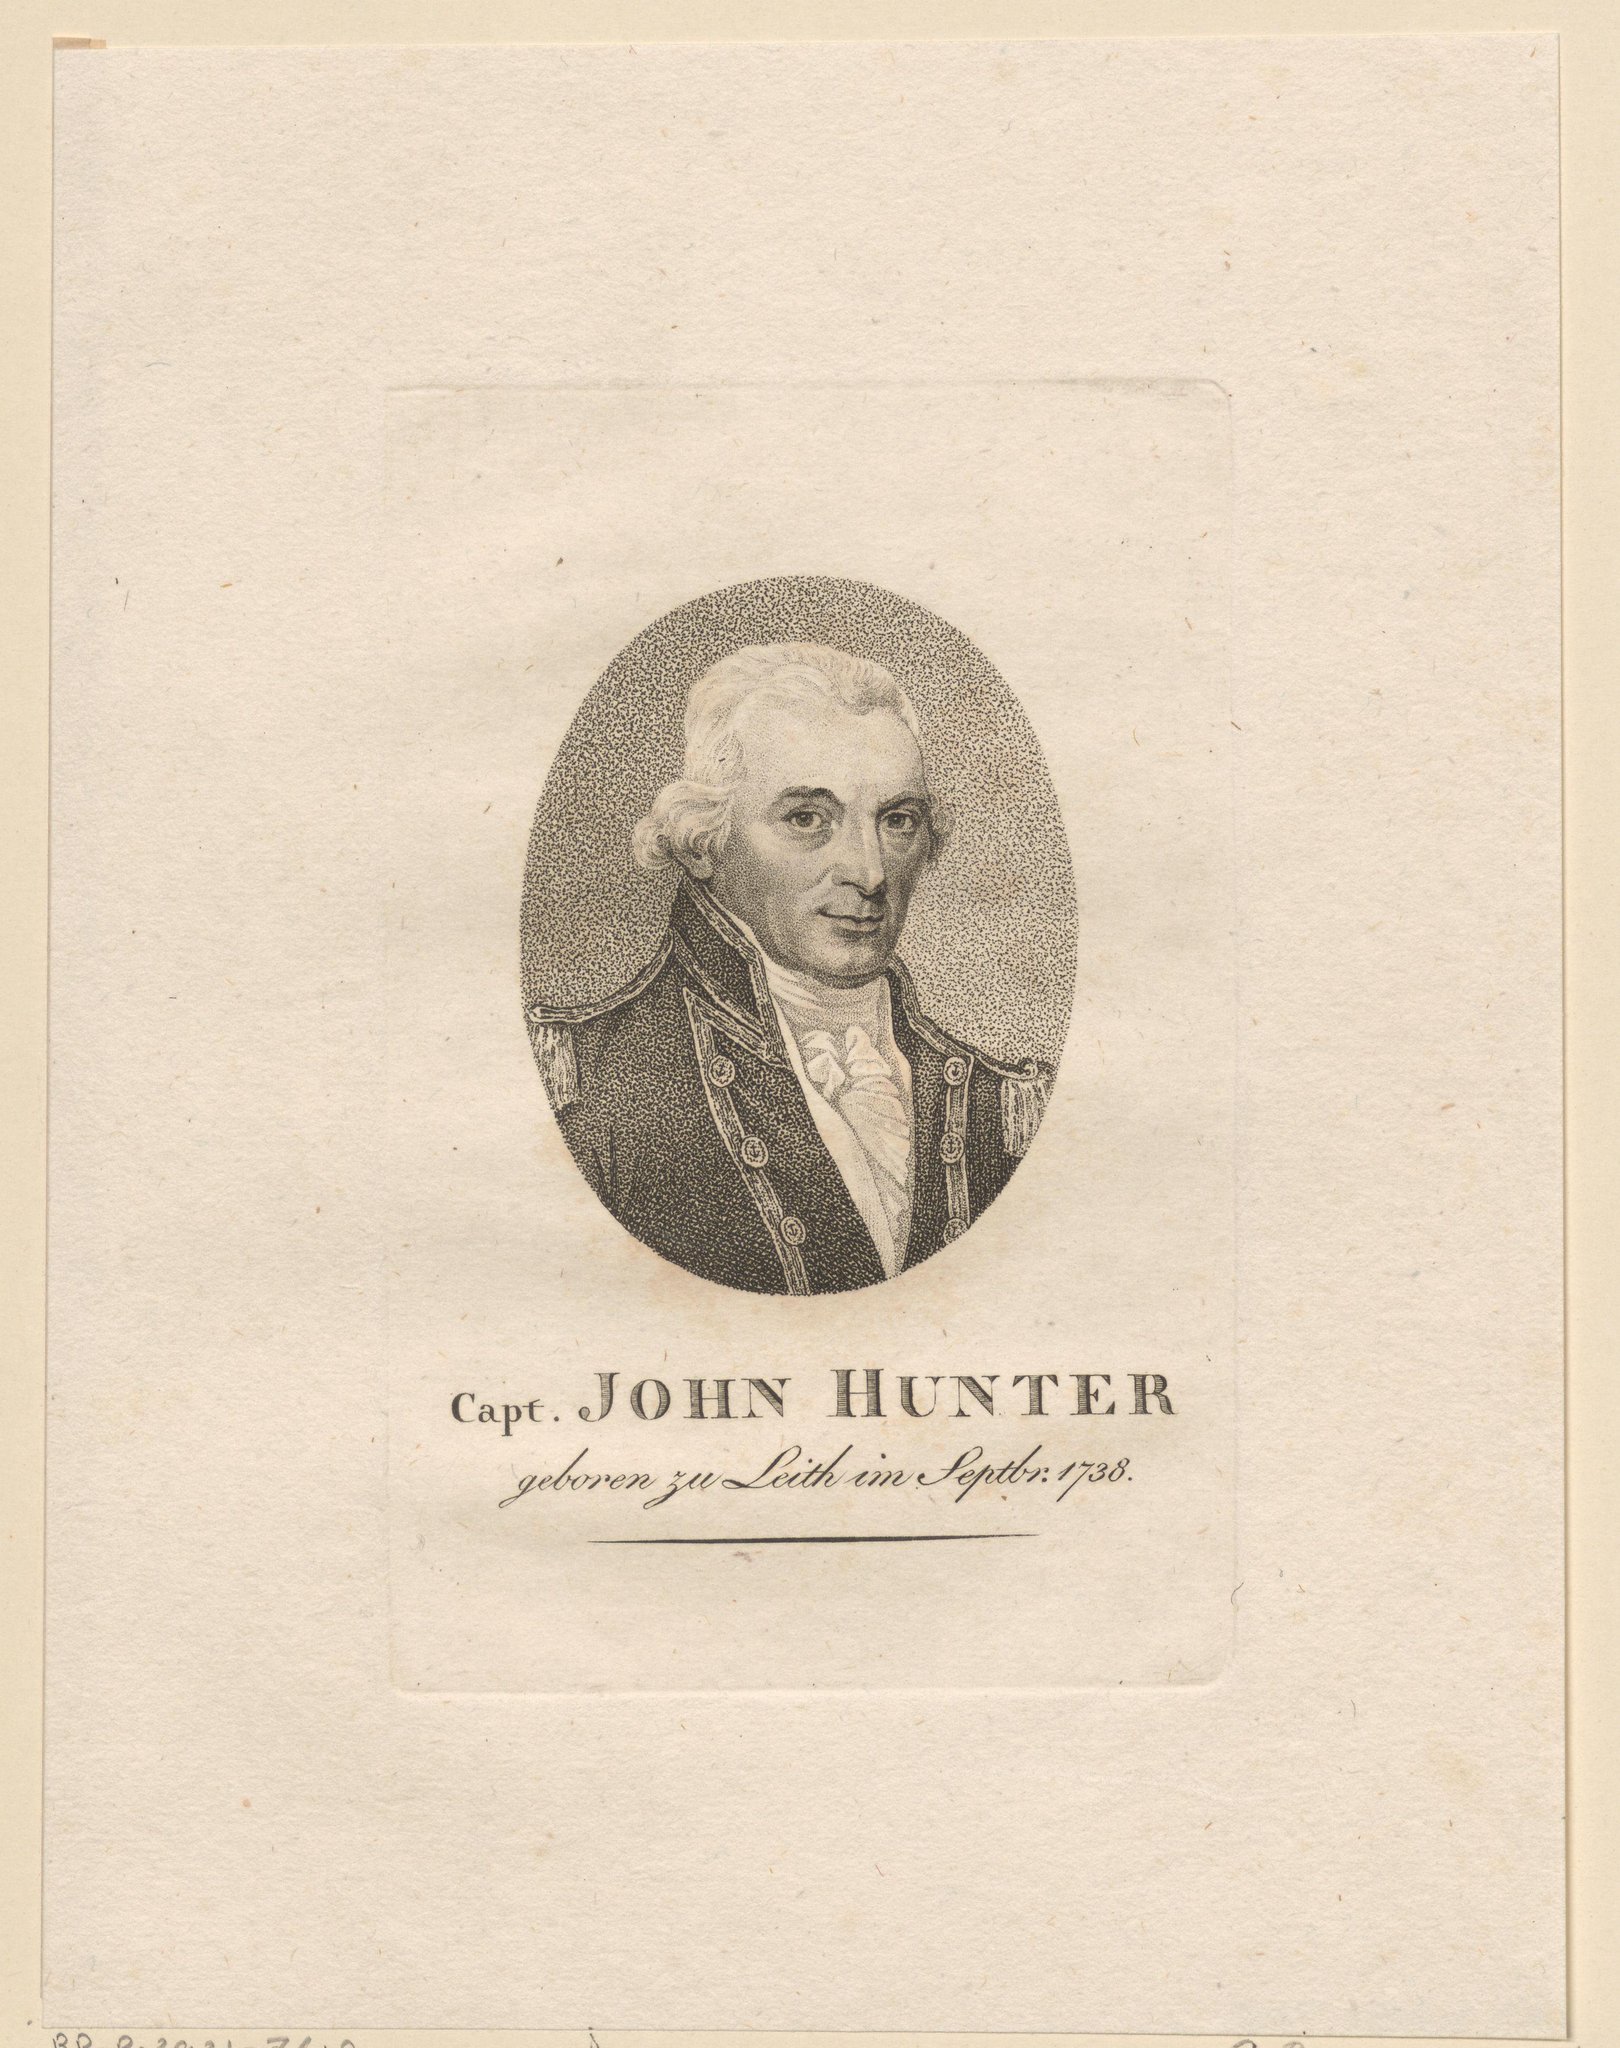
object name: print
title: Portret van John Hunter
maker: Anonymous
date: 1786-1830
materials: paper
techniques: etching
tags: naval officer, john hunter, historical persons, commander-in-chief, admiral